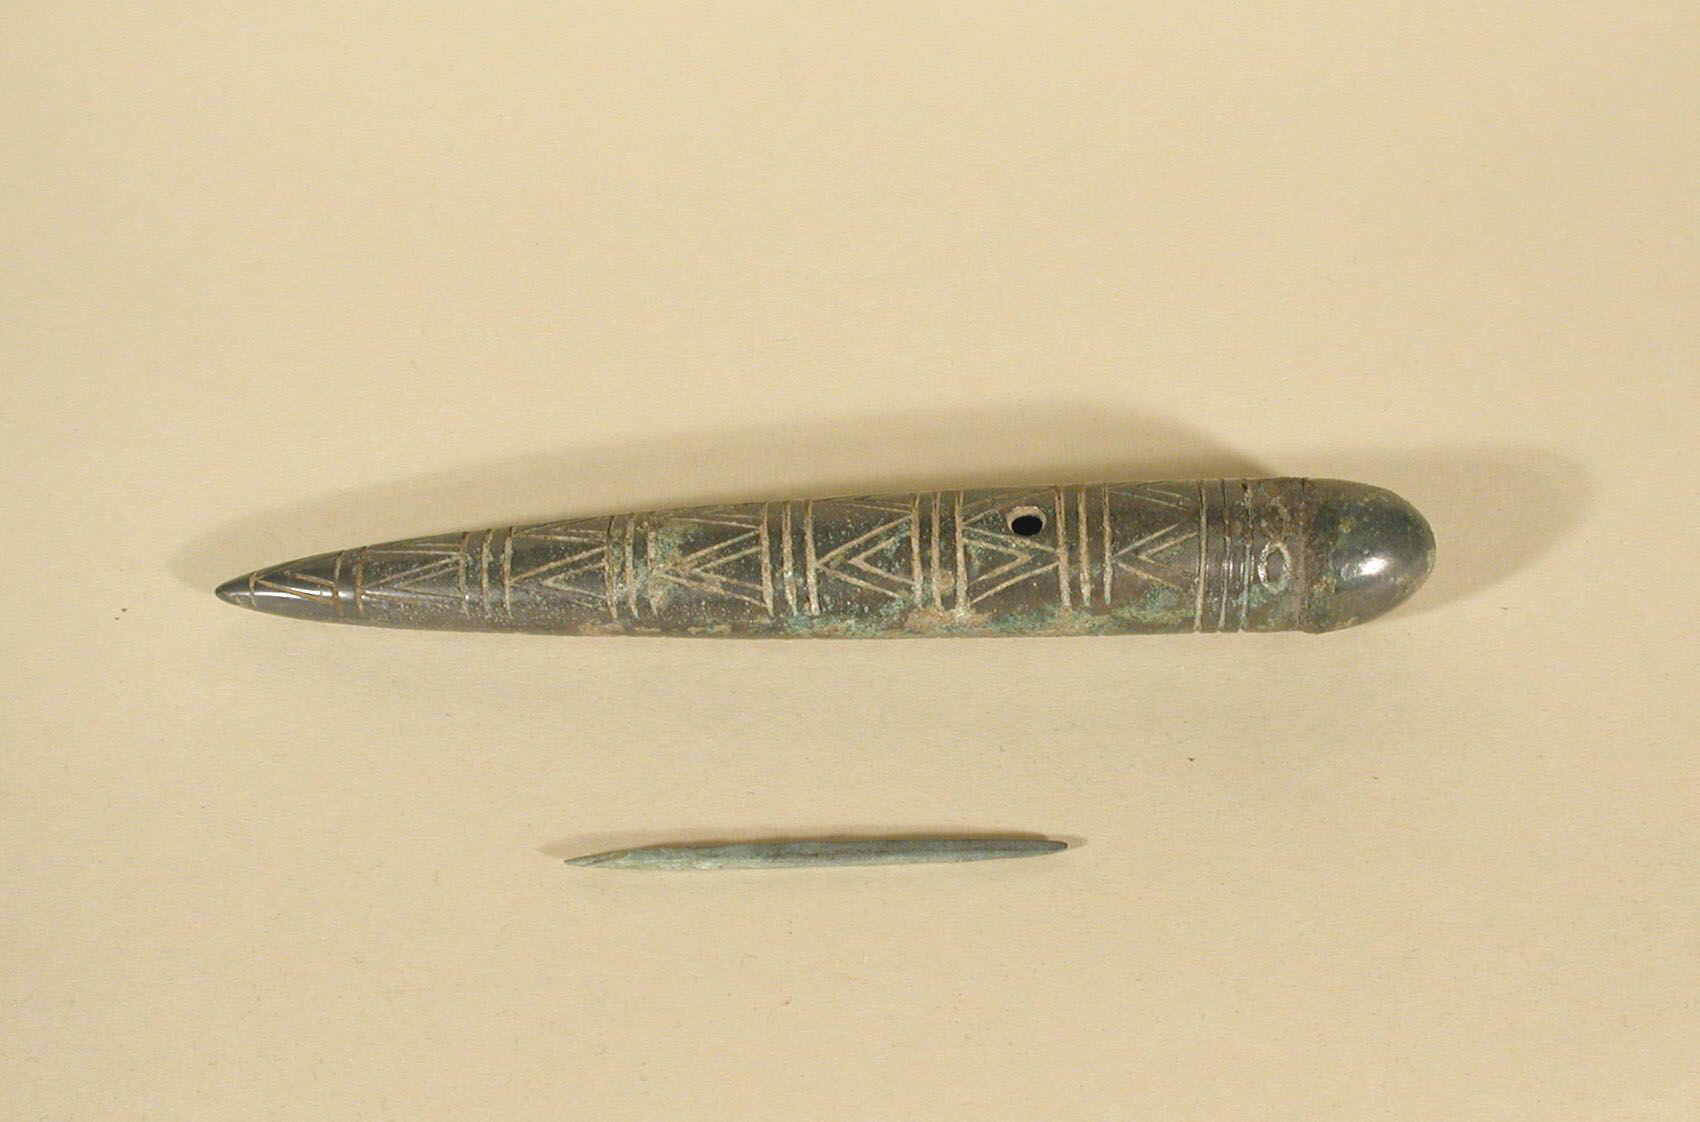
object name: tool with pin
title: Pointed Tubular Tool with Pin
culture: chinese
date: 1000-1 BCE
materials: bronze